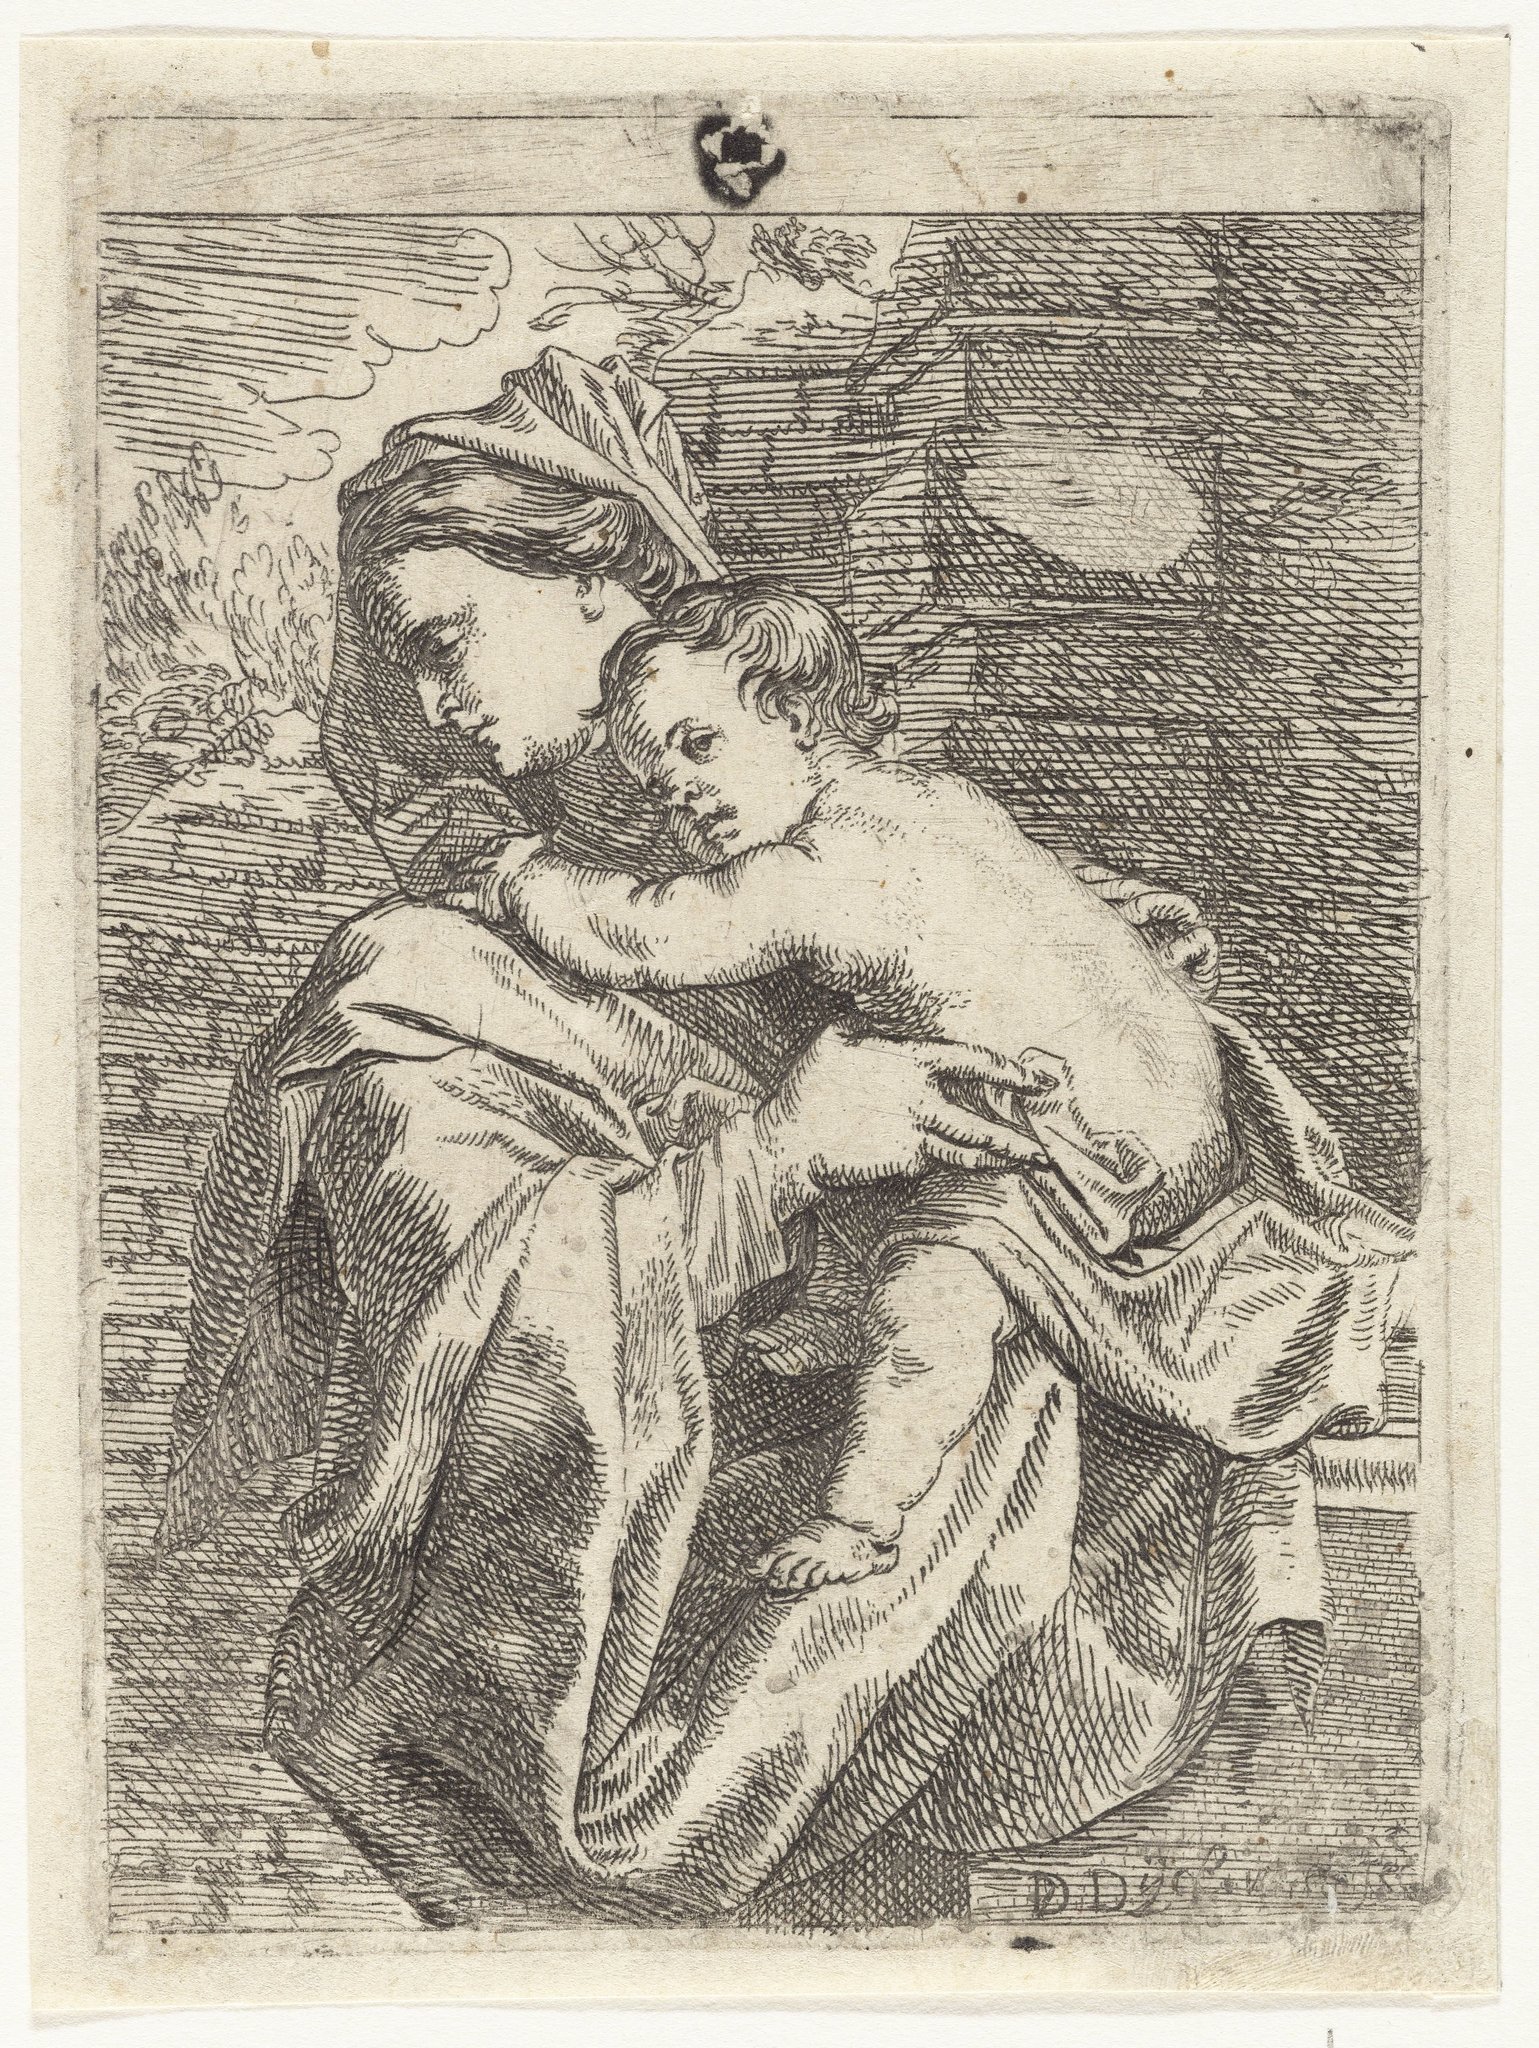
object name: print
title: Maria met Kind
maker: daniël van den dyck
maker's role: draughtsman, painter, print maker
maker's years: 1614-1663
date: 1635-1670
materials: paper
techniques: etching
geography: italy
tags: mary standing (or half-length), the christ-child on her arm (christ-child to mary's left)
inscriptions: collector's mark: Lugt 240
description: Maria met het Kind op haar arm staand voor een bakstenen muur.